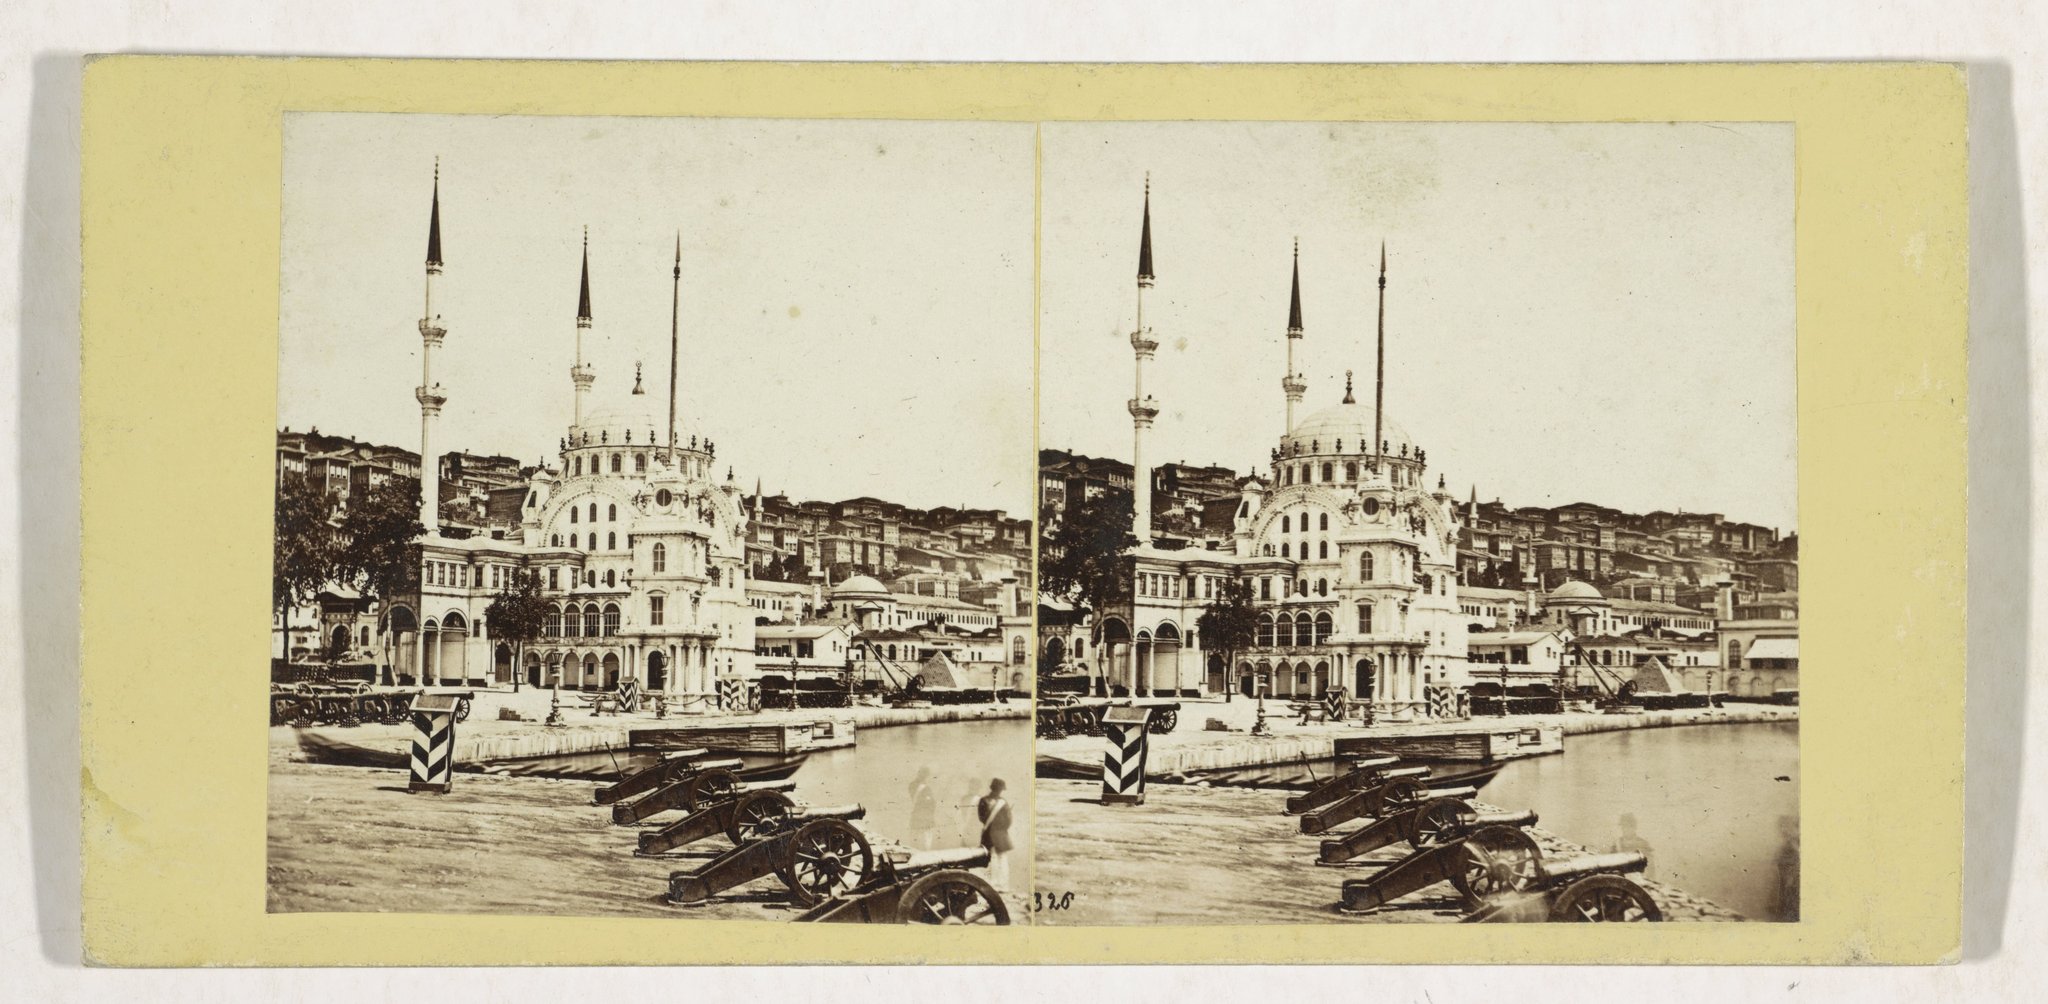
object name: stereograph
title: Nusretiye moskee in Tophane, Istanboel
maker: charles gaudin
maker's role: publisher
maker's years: 1825-1905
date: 1861-1870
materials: cardboard, paper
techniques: albumen print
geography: nusretiye moskee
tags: temple, shrine ~ islam, mohammedanism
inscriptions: inscription: ‘La mosquée de Cop-LLama, Constantinople [?]’, number: ‘328’